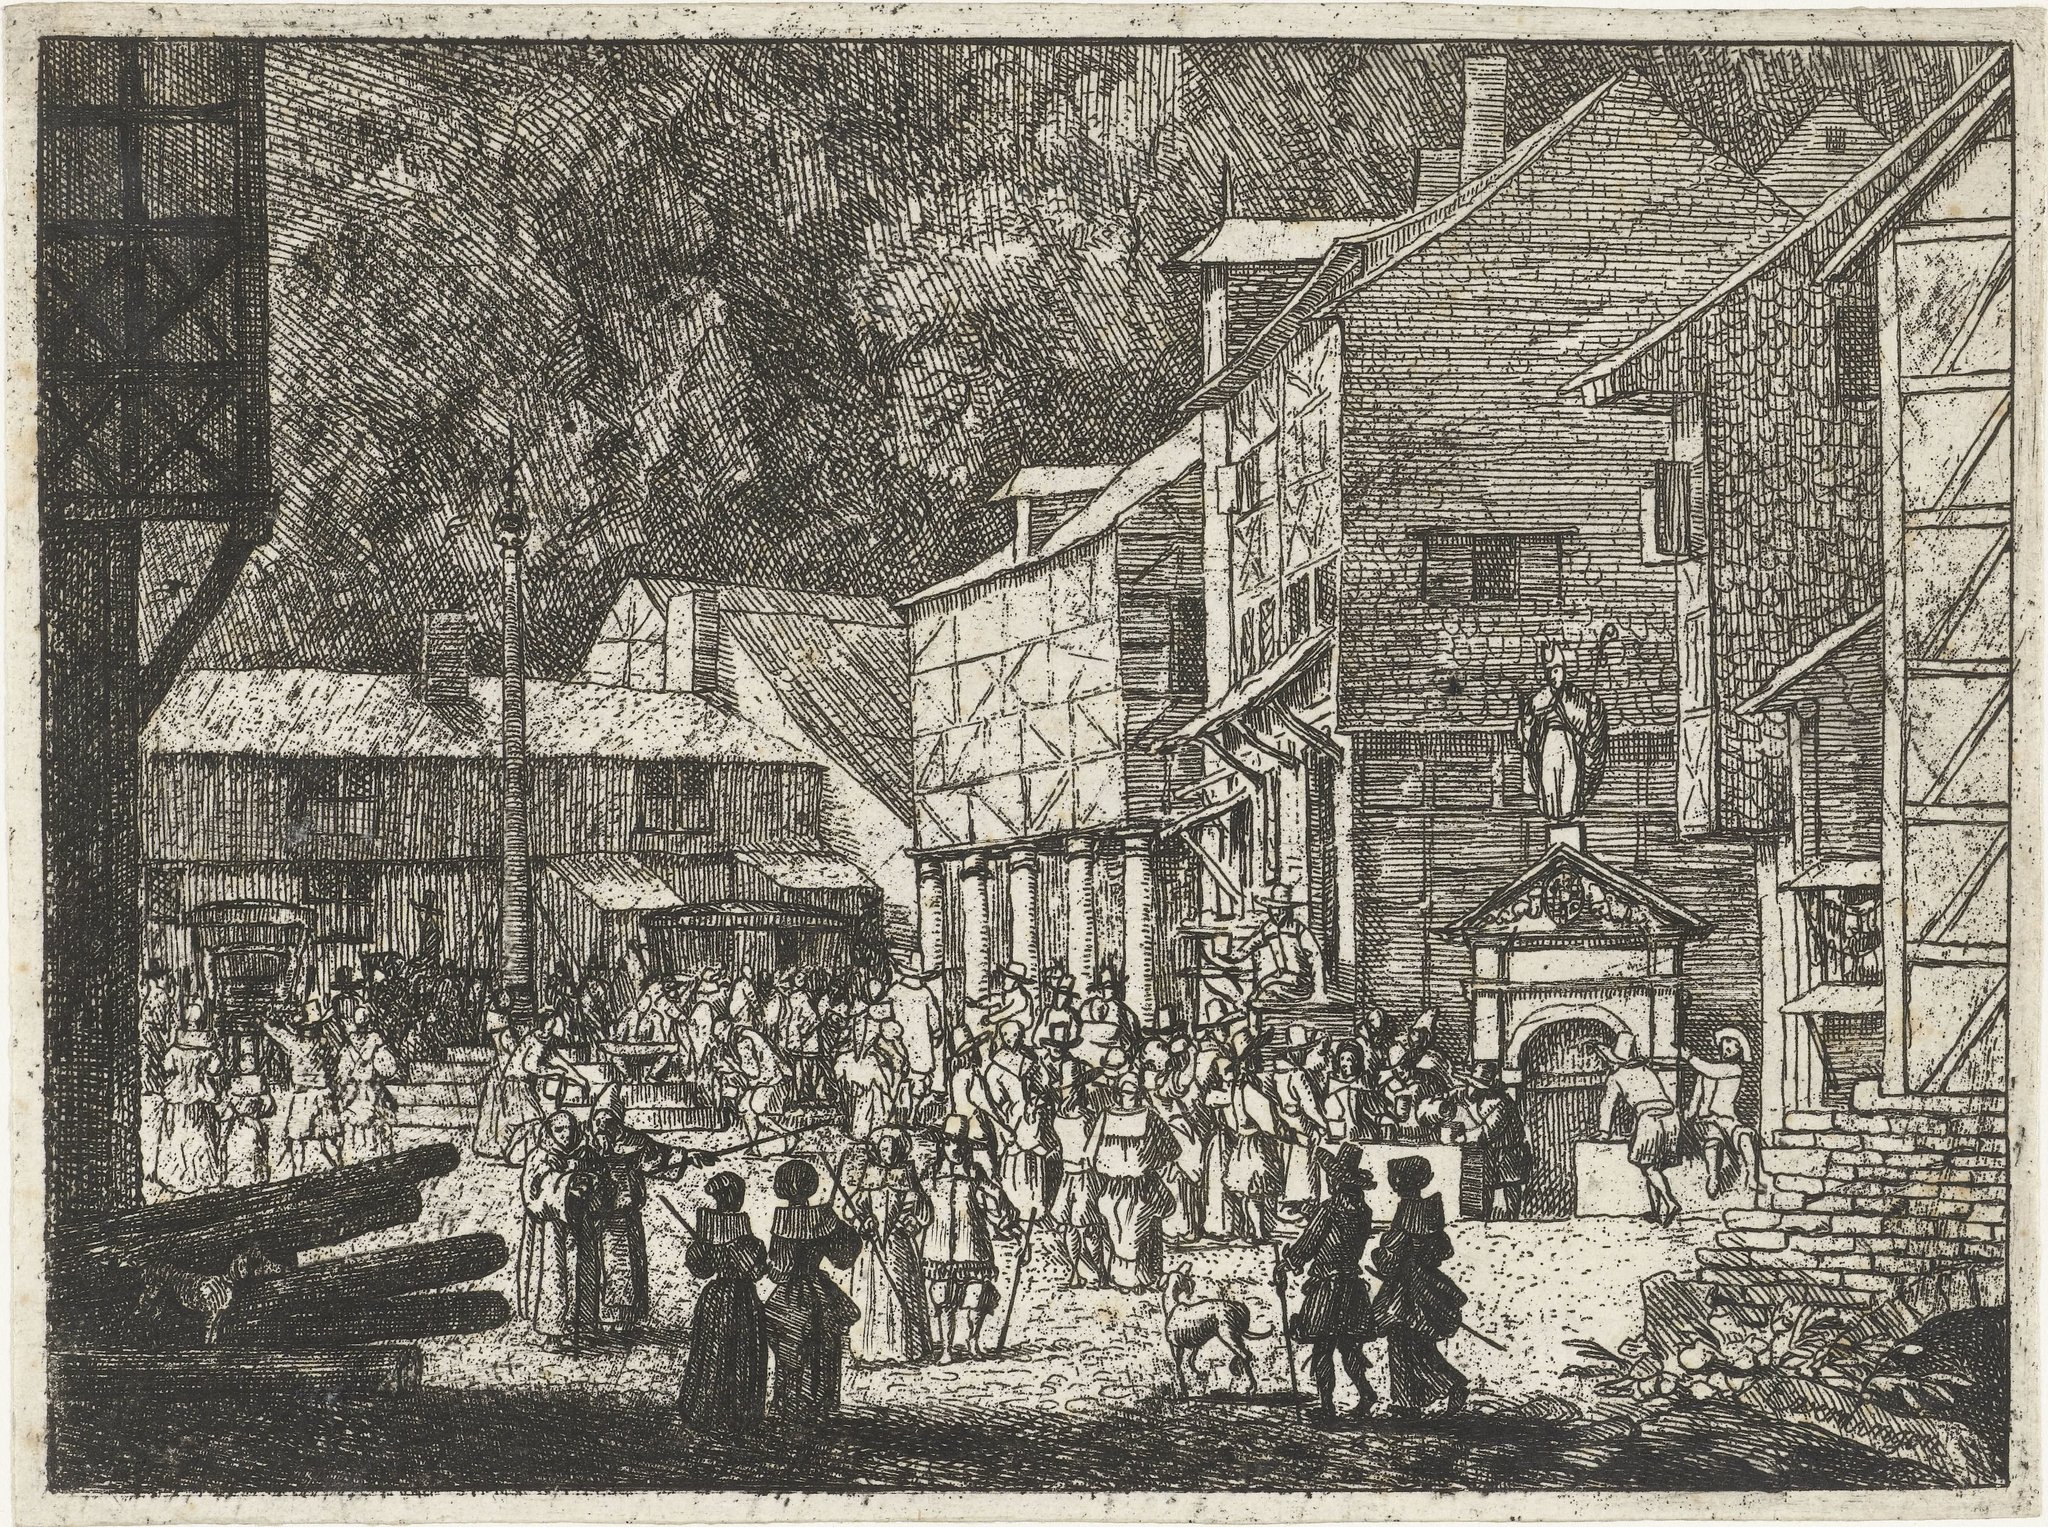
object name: print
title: Vier waterbronnen in en rond Spa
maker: allaert van everdingen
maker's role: draughtsman, painter, print maker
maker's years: 1621-1675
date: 1631-1675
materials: paper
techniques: etching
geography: netherlands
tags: spring (fluids extracted from the earth)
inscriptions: collector's mark: Lugt 1904, collector's mark: Lugt 2760, collector's mark: Lugt 2228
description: Gezicht op een druk, door huizen omsloten, plein. Vanuit de waterbon, waarboven een standbeeld van een heilige, wordt water uitgedeeld.